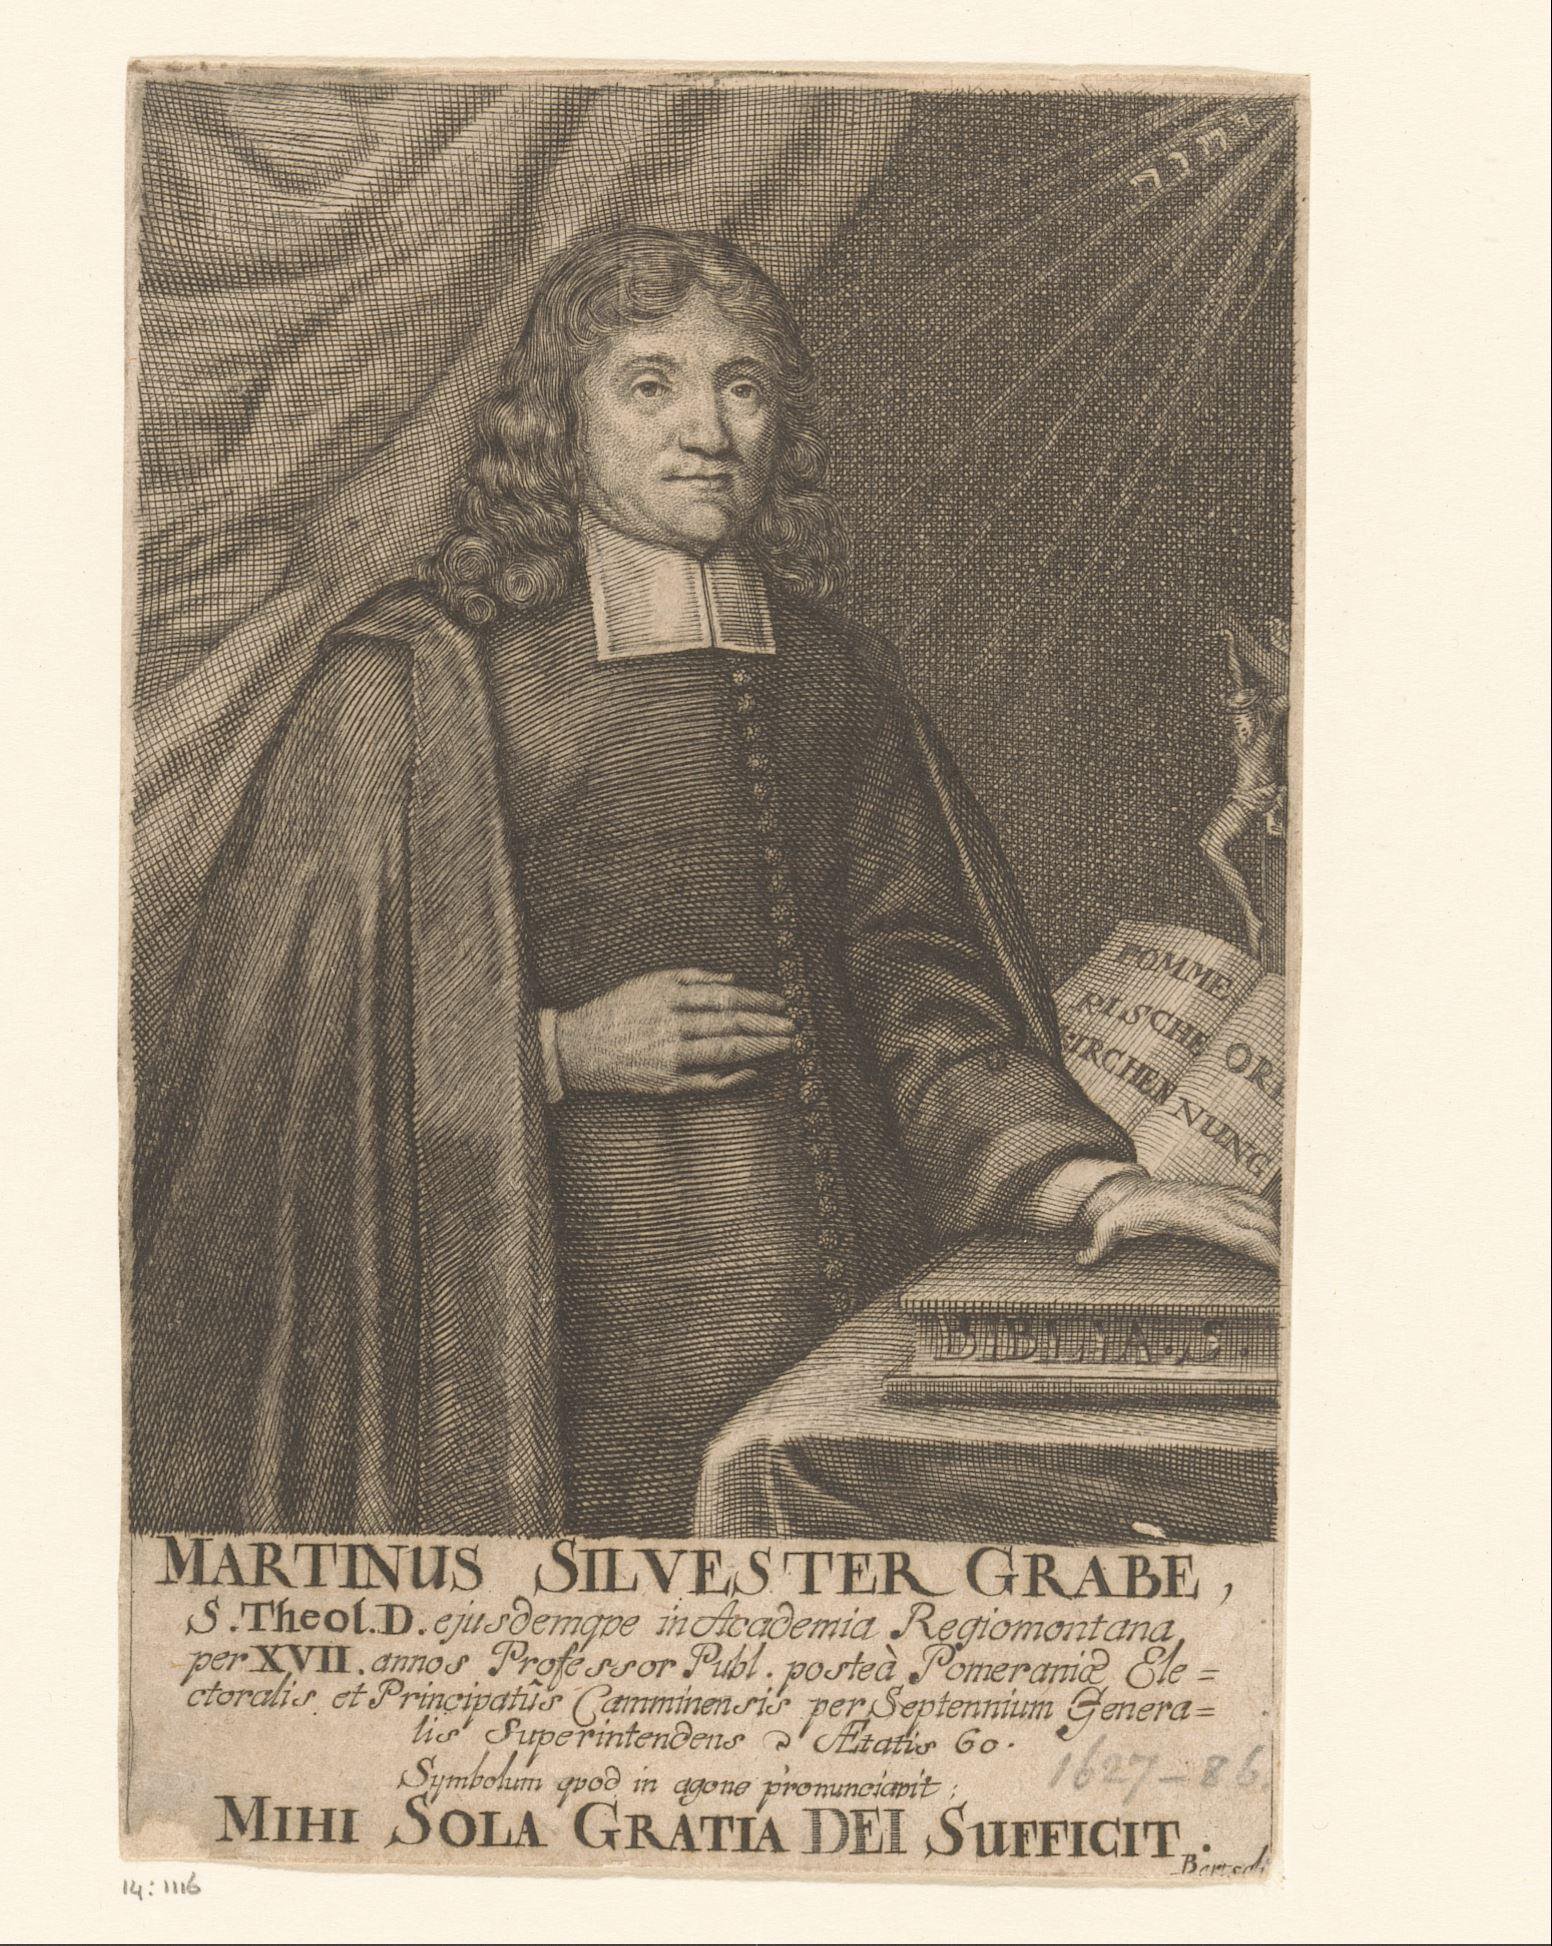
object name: print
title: Martinus Silvester Grabe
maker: Anonymous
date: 1694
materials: paper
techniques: engraving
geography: germany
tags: historical persons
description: Prent ook gebruikt als boekillustratie in: Kongehl, Michael. Immergrünender Cypressen-Hayn. Danzig: Martin Hallervordt, 1694.